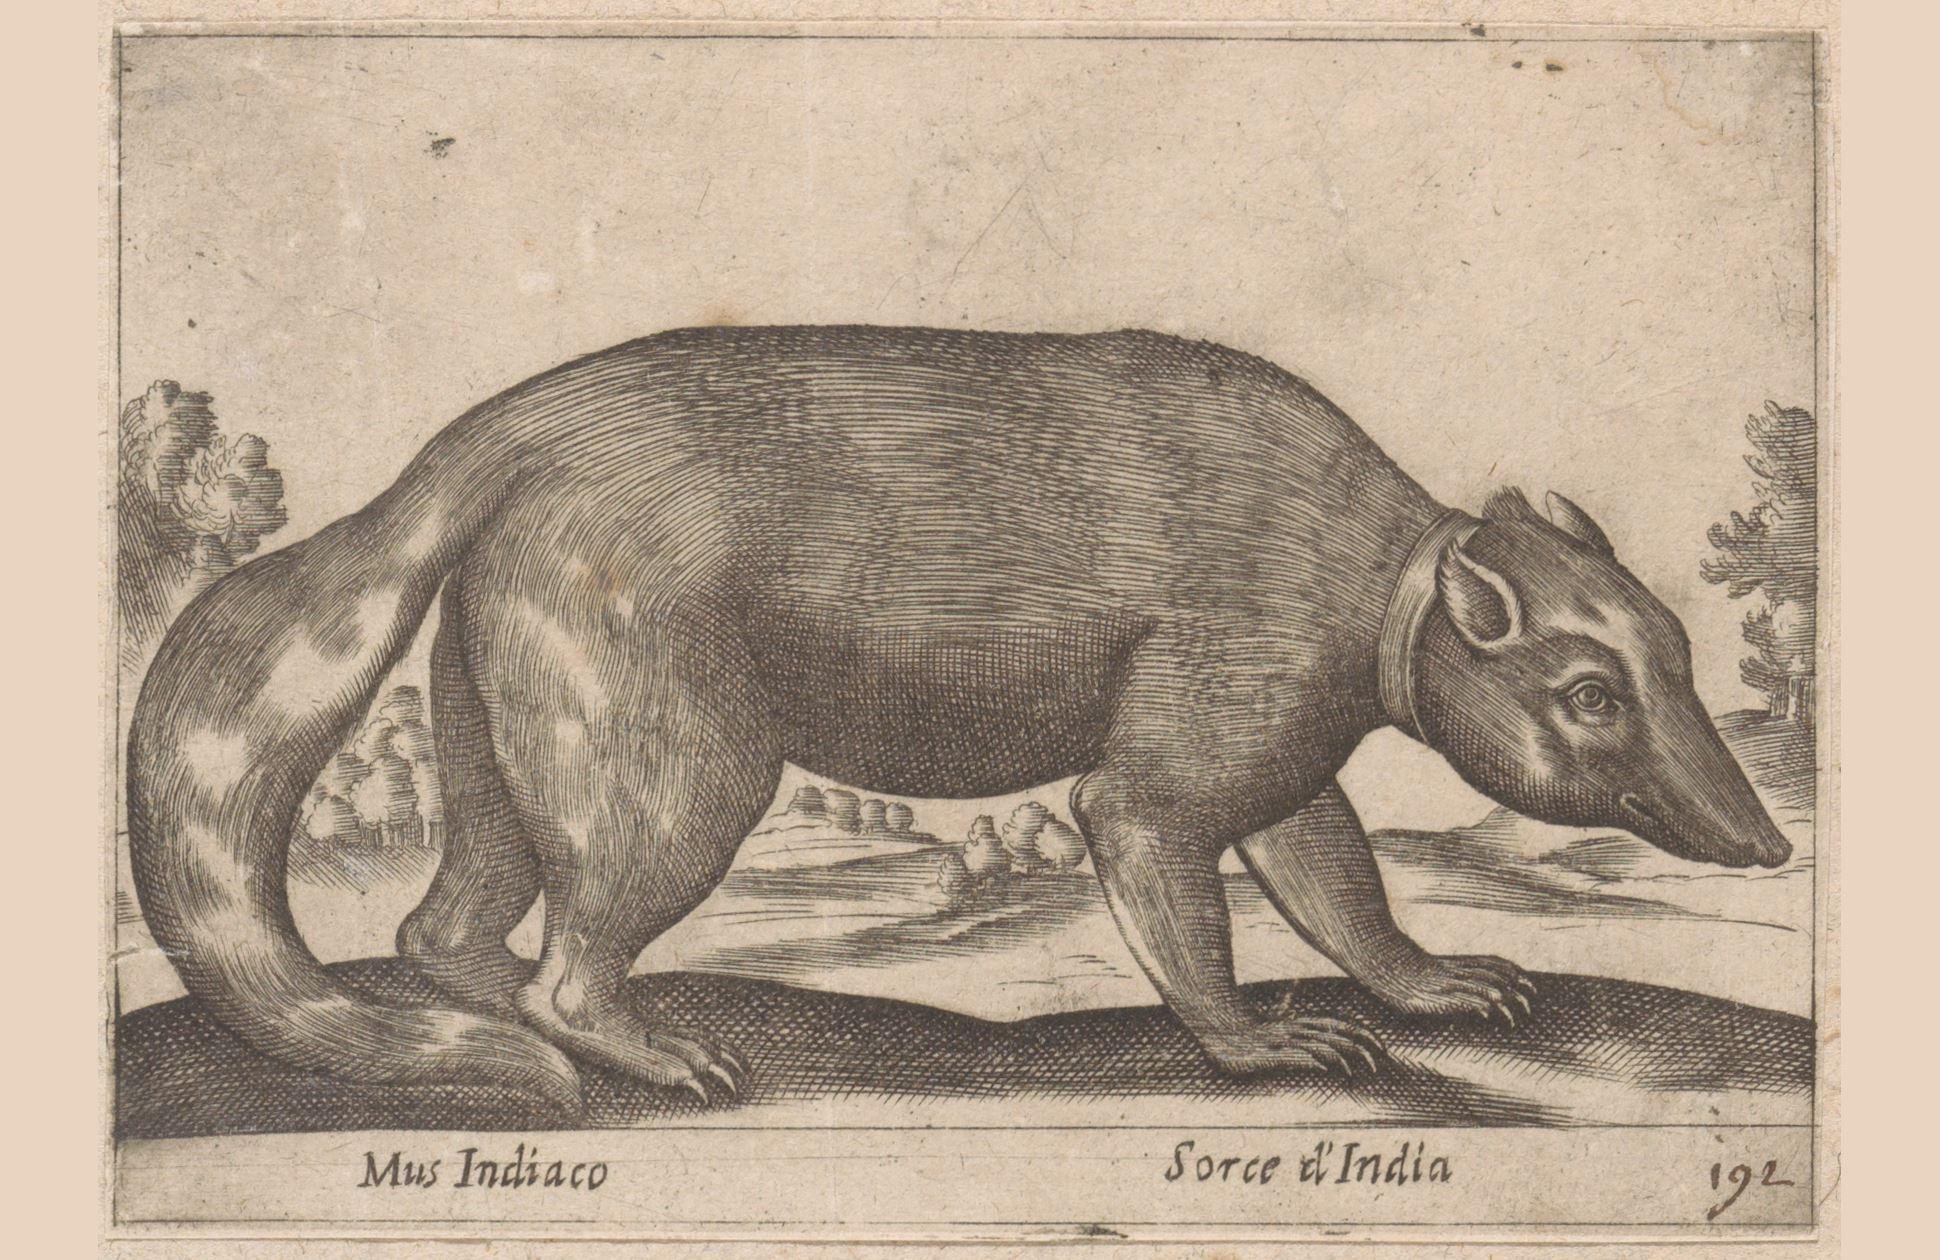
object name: print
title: Rode neusbeer of Zuid-Amerikaanse coati (Nasua nasua)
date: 1565-1630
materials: paper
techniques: etching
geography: rome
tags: other mammels: coati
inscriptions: number: ‘192’, collector's mark: Lugt 11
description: Deze voorstelling is ontleend aan Conrad Gessner, Historia Animalium (1551-1587), waar het dier wordt aangeduid Mus Indicus. De aquarel van Felix Platter die ten grondslag ligt aan Gessners houtsnede wordt door Florike Egmond geïdentificeerd als Rode neusbeer of Zuid-Amerikaanse coati (Nasua nasua). Deze prent maakt deel uit van een reeks prenten van dieren door Antonio Tempesta. Bekend is dat een tweede staat (met nummering) van deze serie is uitgegeven door Giovanni Giacomo de' Rossi in 1650. Onbekend is wie de eerste staat heeft uitgegeven en wanneer.